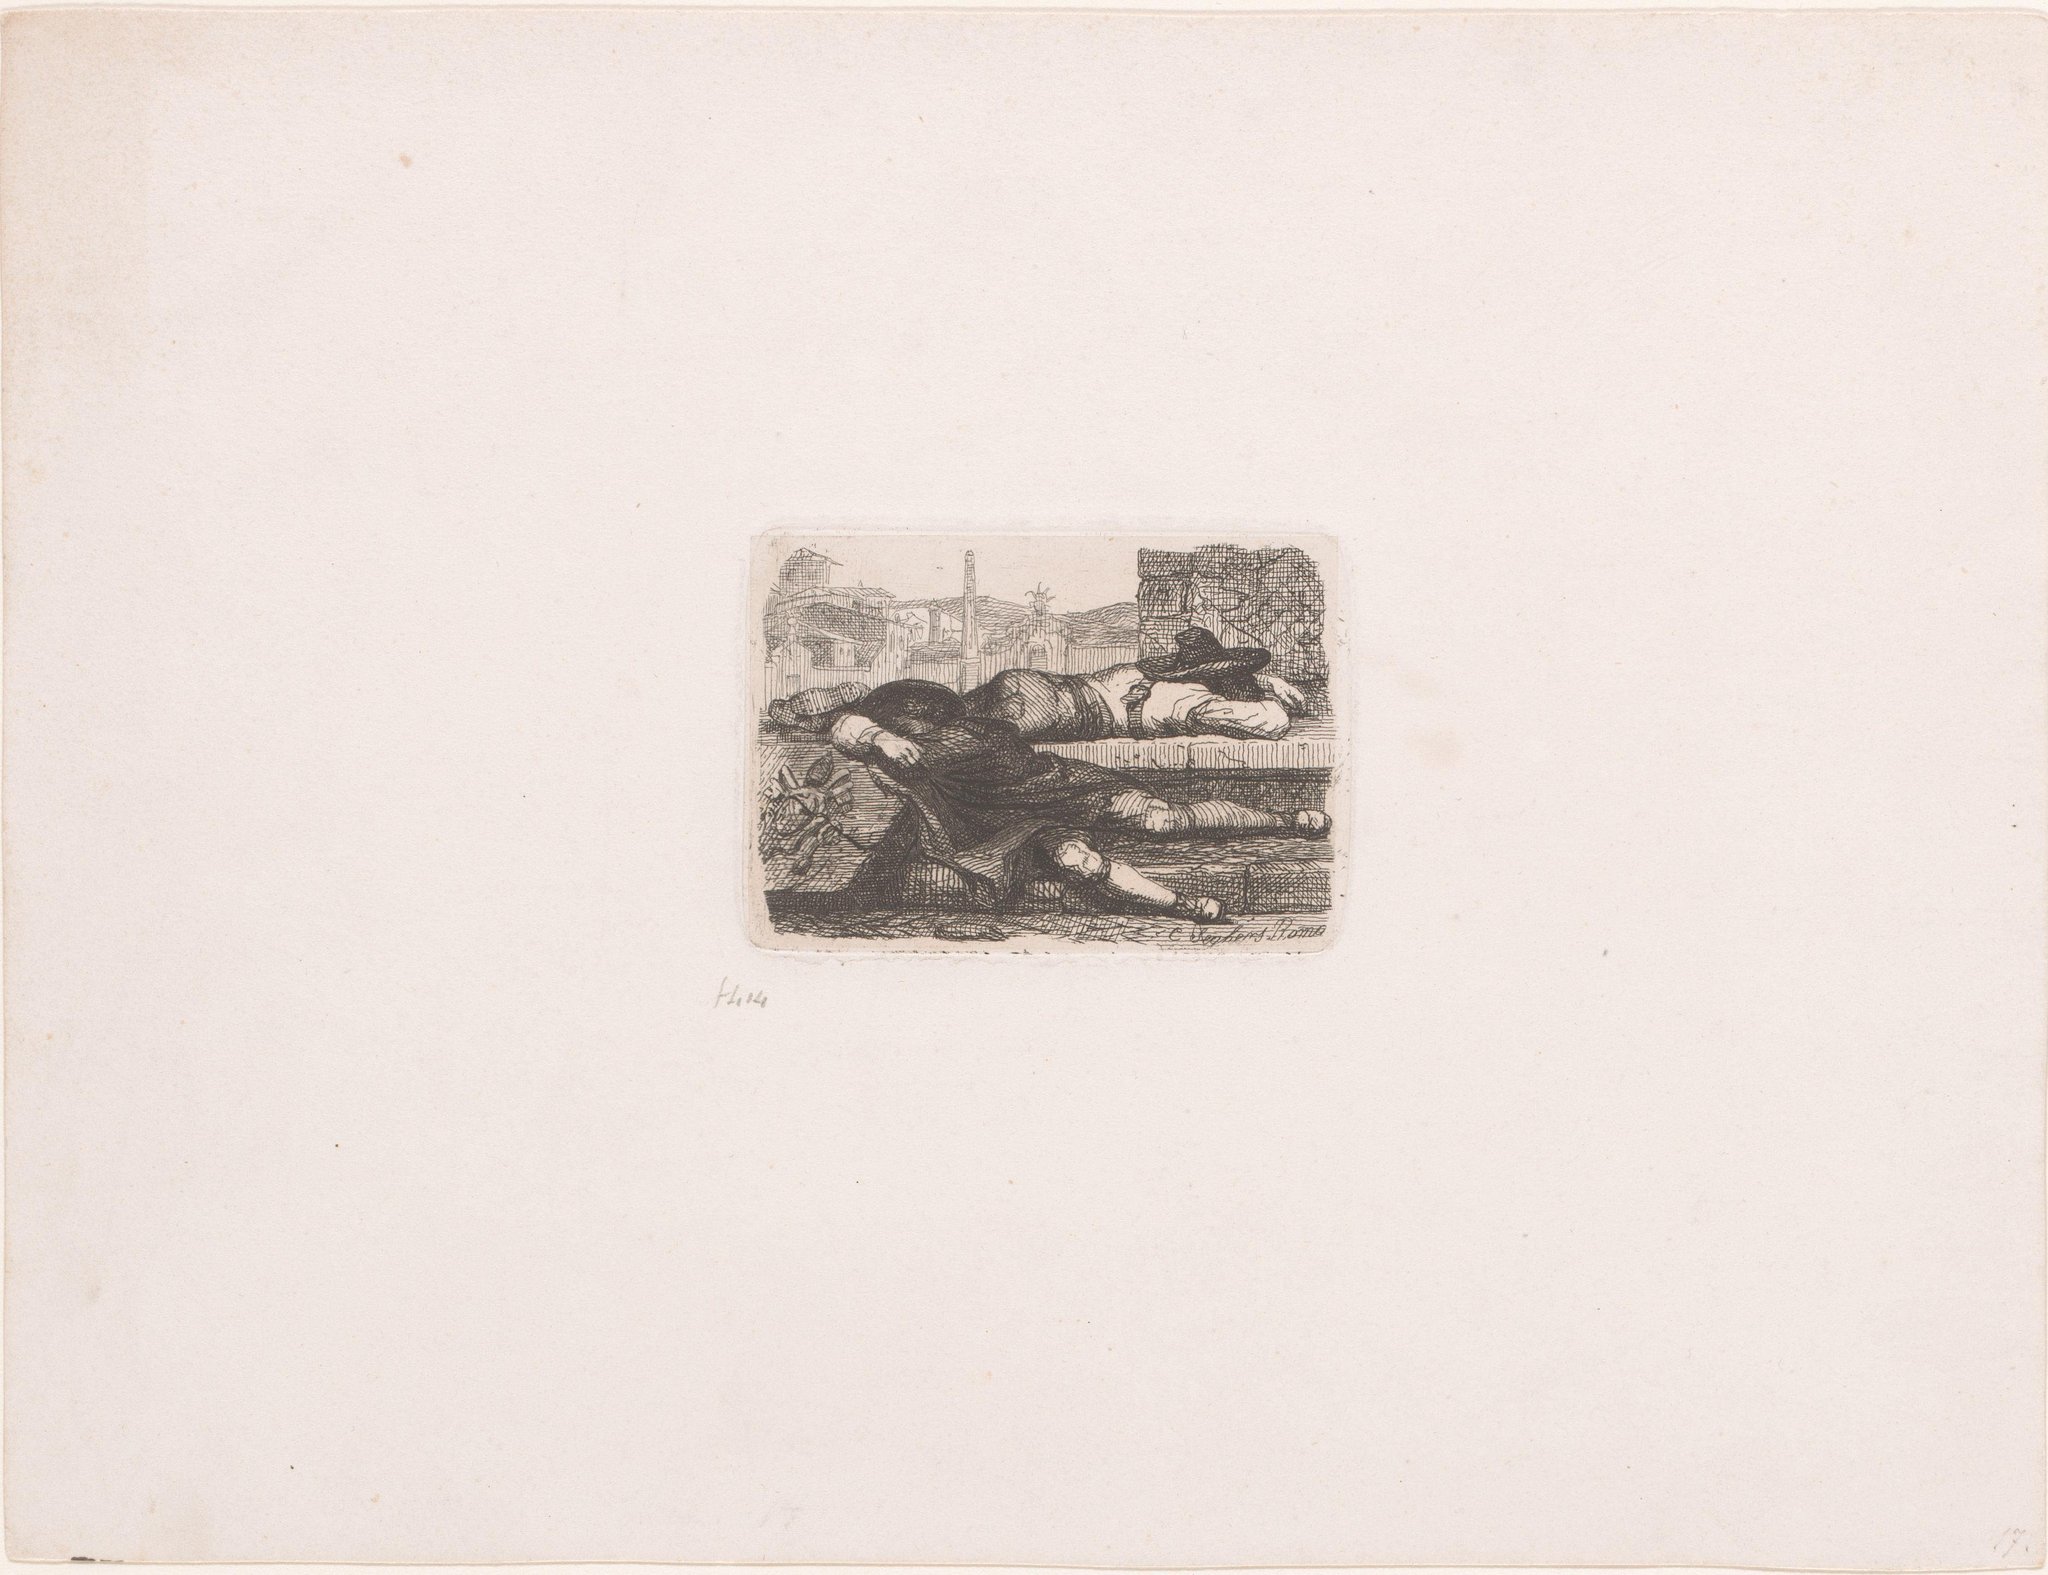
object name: print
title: Twee mannen slapen siësta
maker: corneille seghers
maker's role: draughtsman, print maker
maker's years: 1814-1869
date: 1824-1869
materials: paper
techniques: etching, intaglio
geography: rome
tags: siesta - bb - out of doors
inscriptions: collector's mark: Lugt 2228